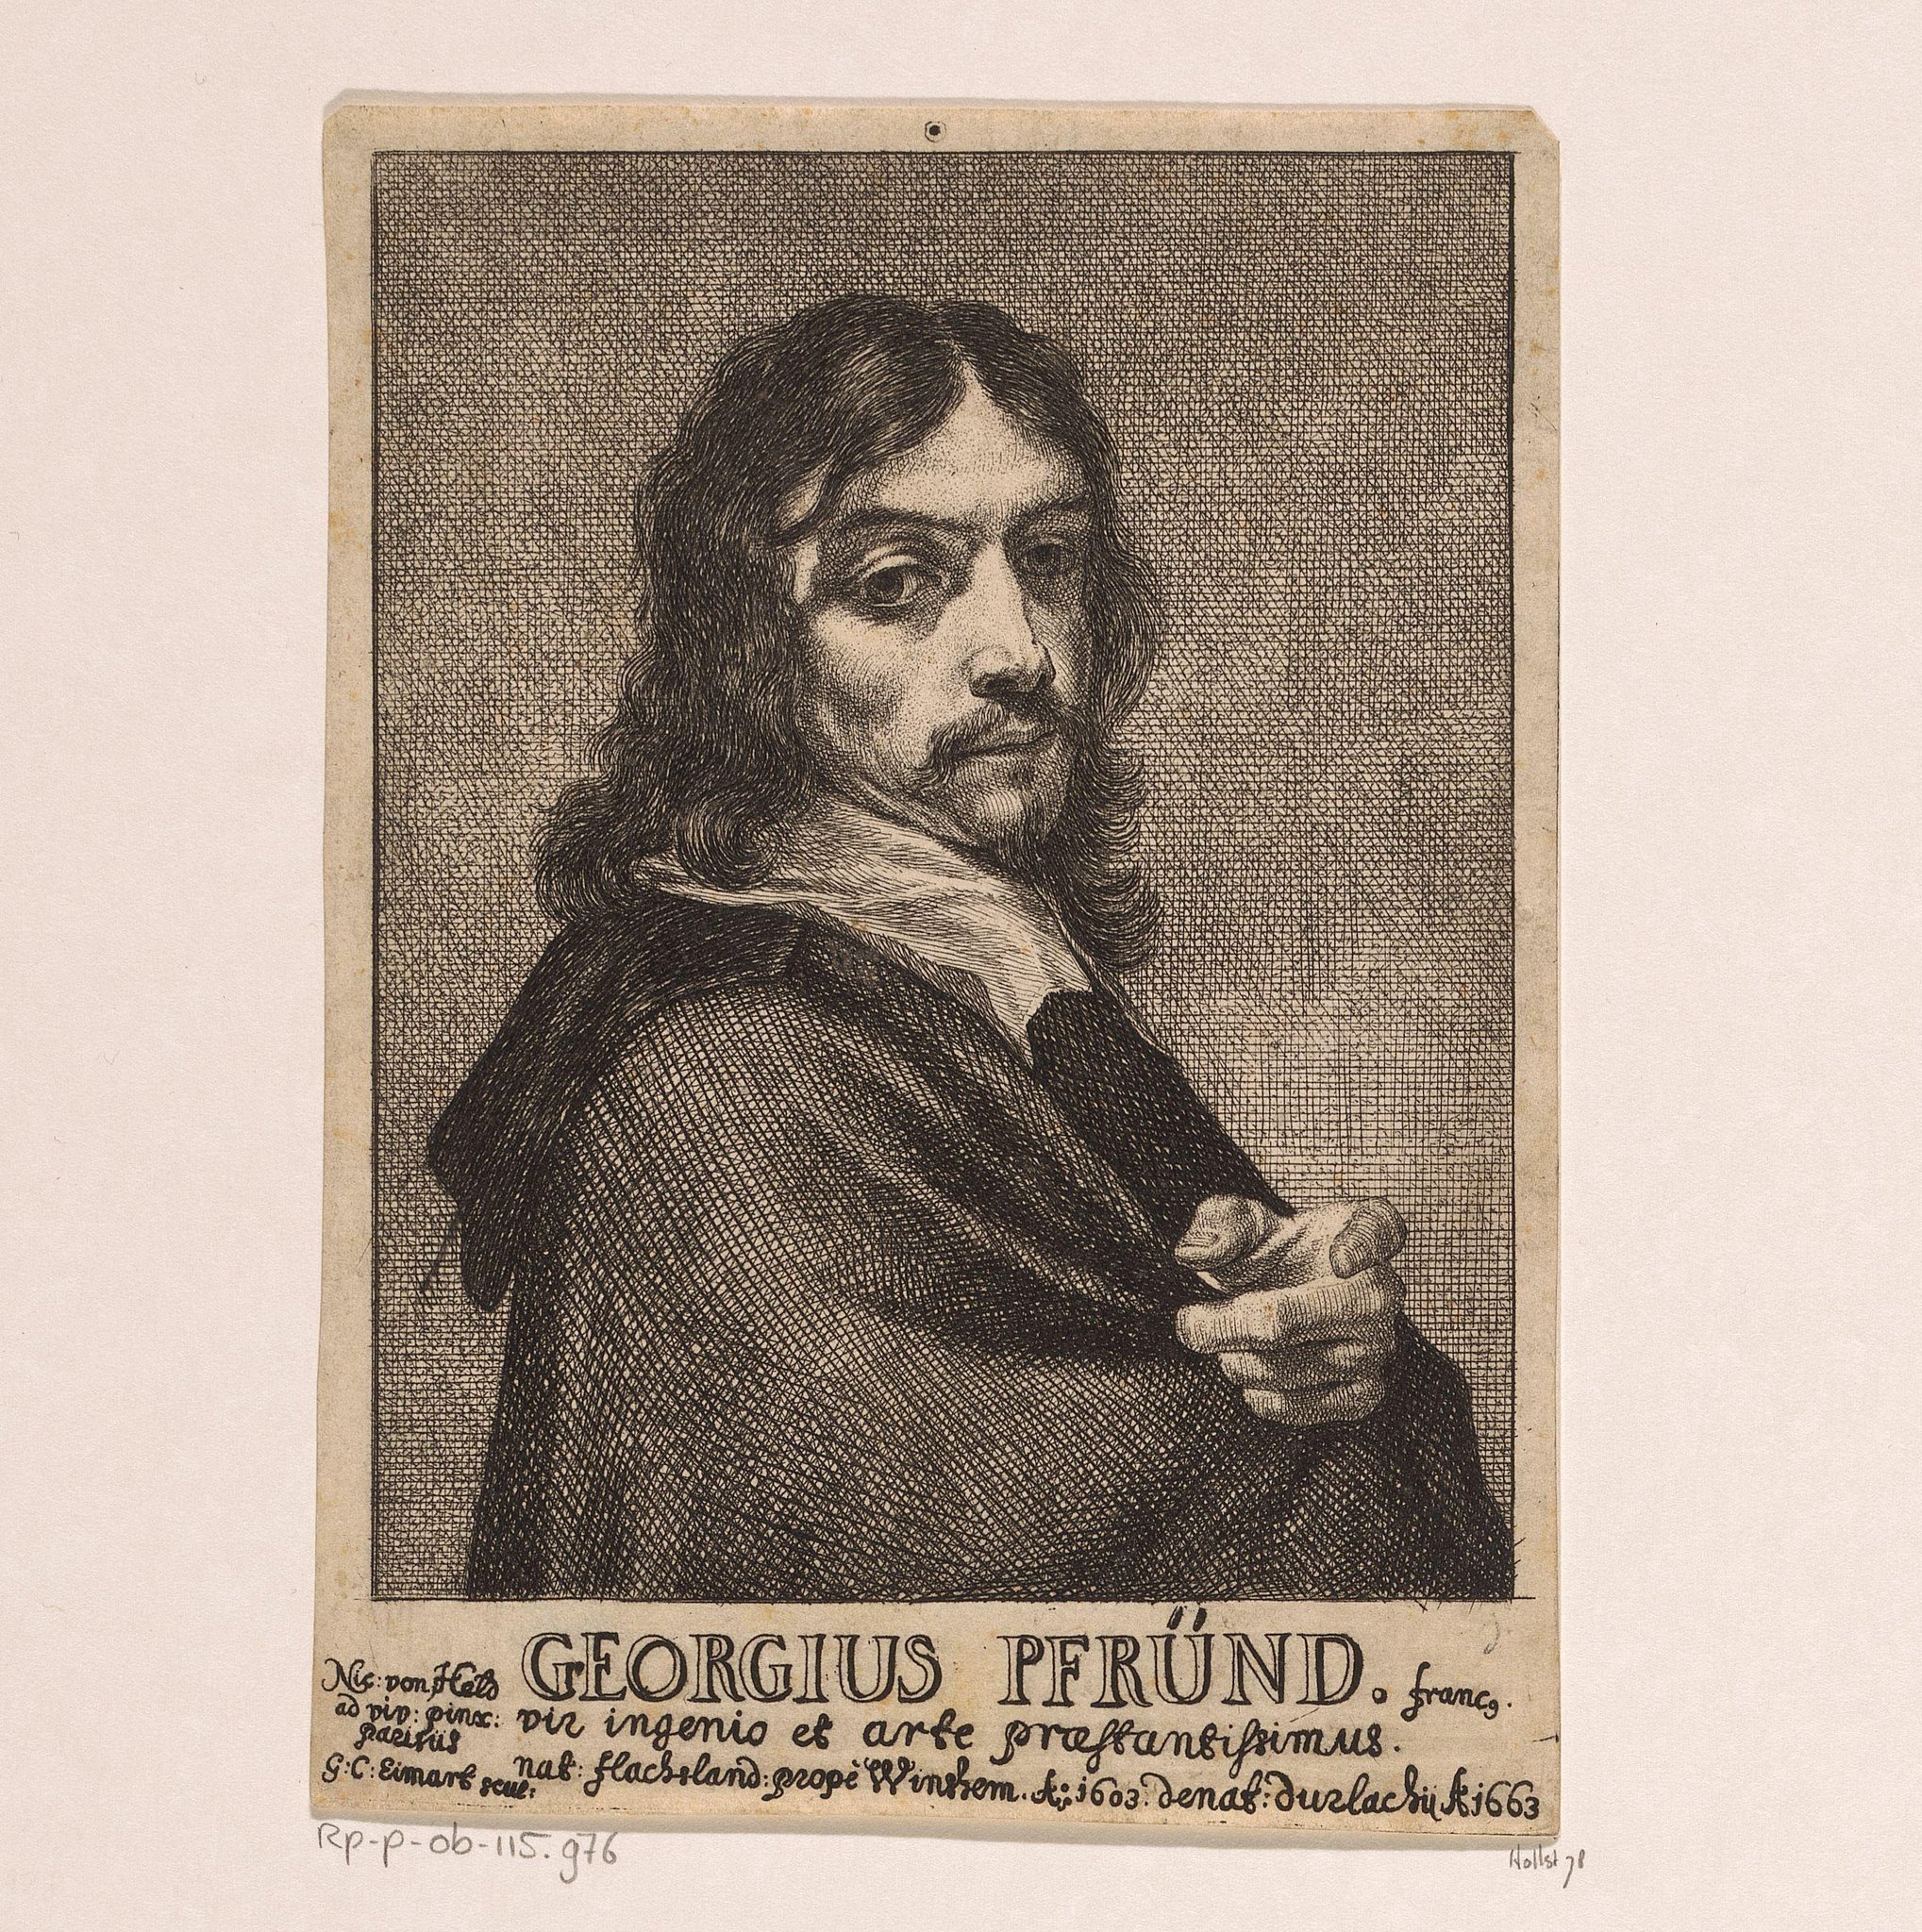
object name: print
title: Portret van Georg Pfründ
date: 1663-1705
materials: paper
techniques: etching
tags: historical persons, index finger forwards, pointing, indicating